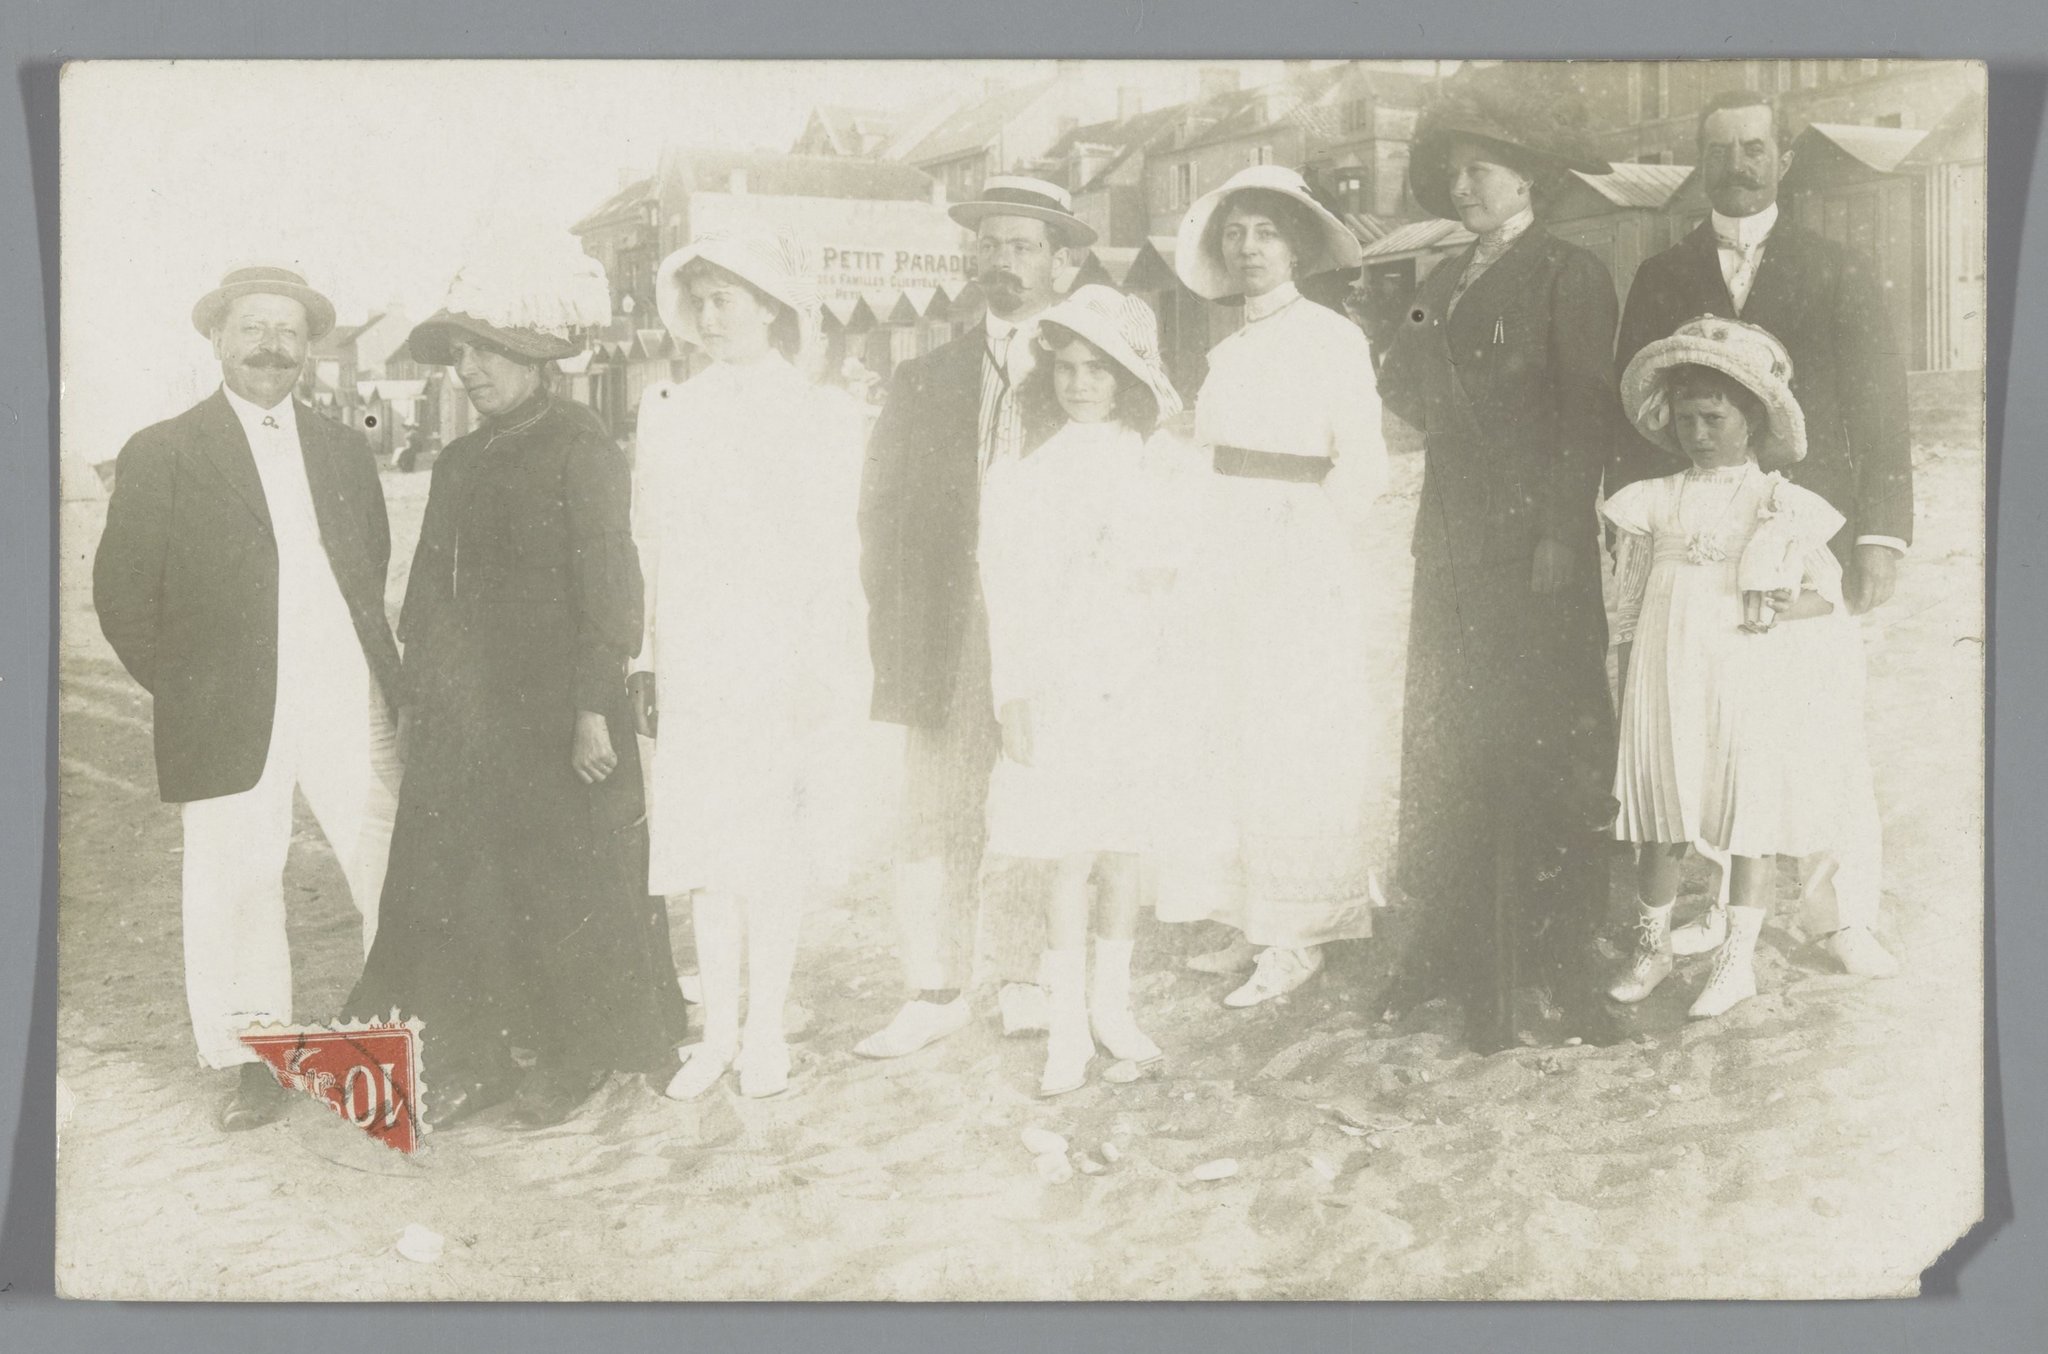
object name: photograph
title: Groepsportret van een onbekende familie op een strand (vermoedelijk) te Frankrijk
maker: Anonymous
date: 1920-1930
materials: photographic support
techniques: gelatin silver print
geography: france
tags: beach (as place of recreation), family group, especially parents with their child(ren)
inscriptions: inscription: ‘Jeanne a été (...) L. Mariniée’